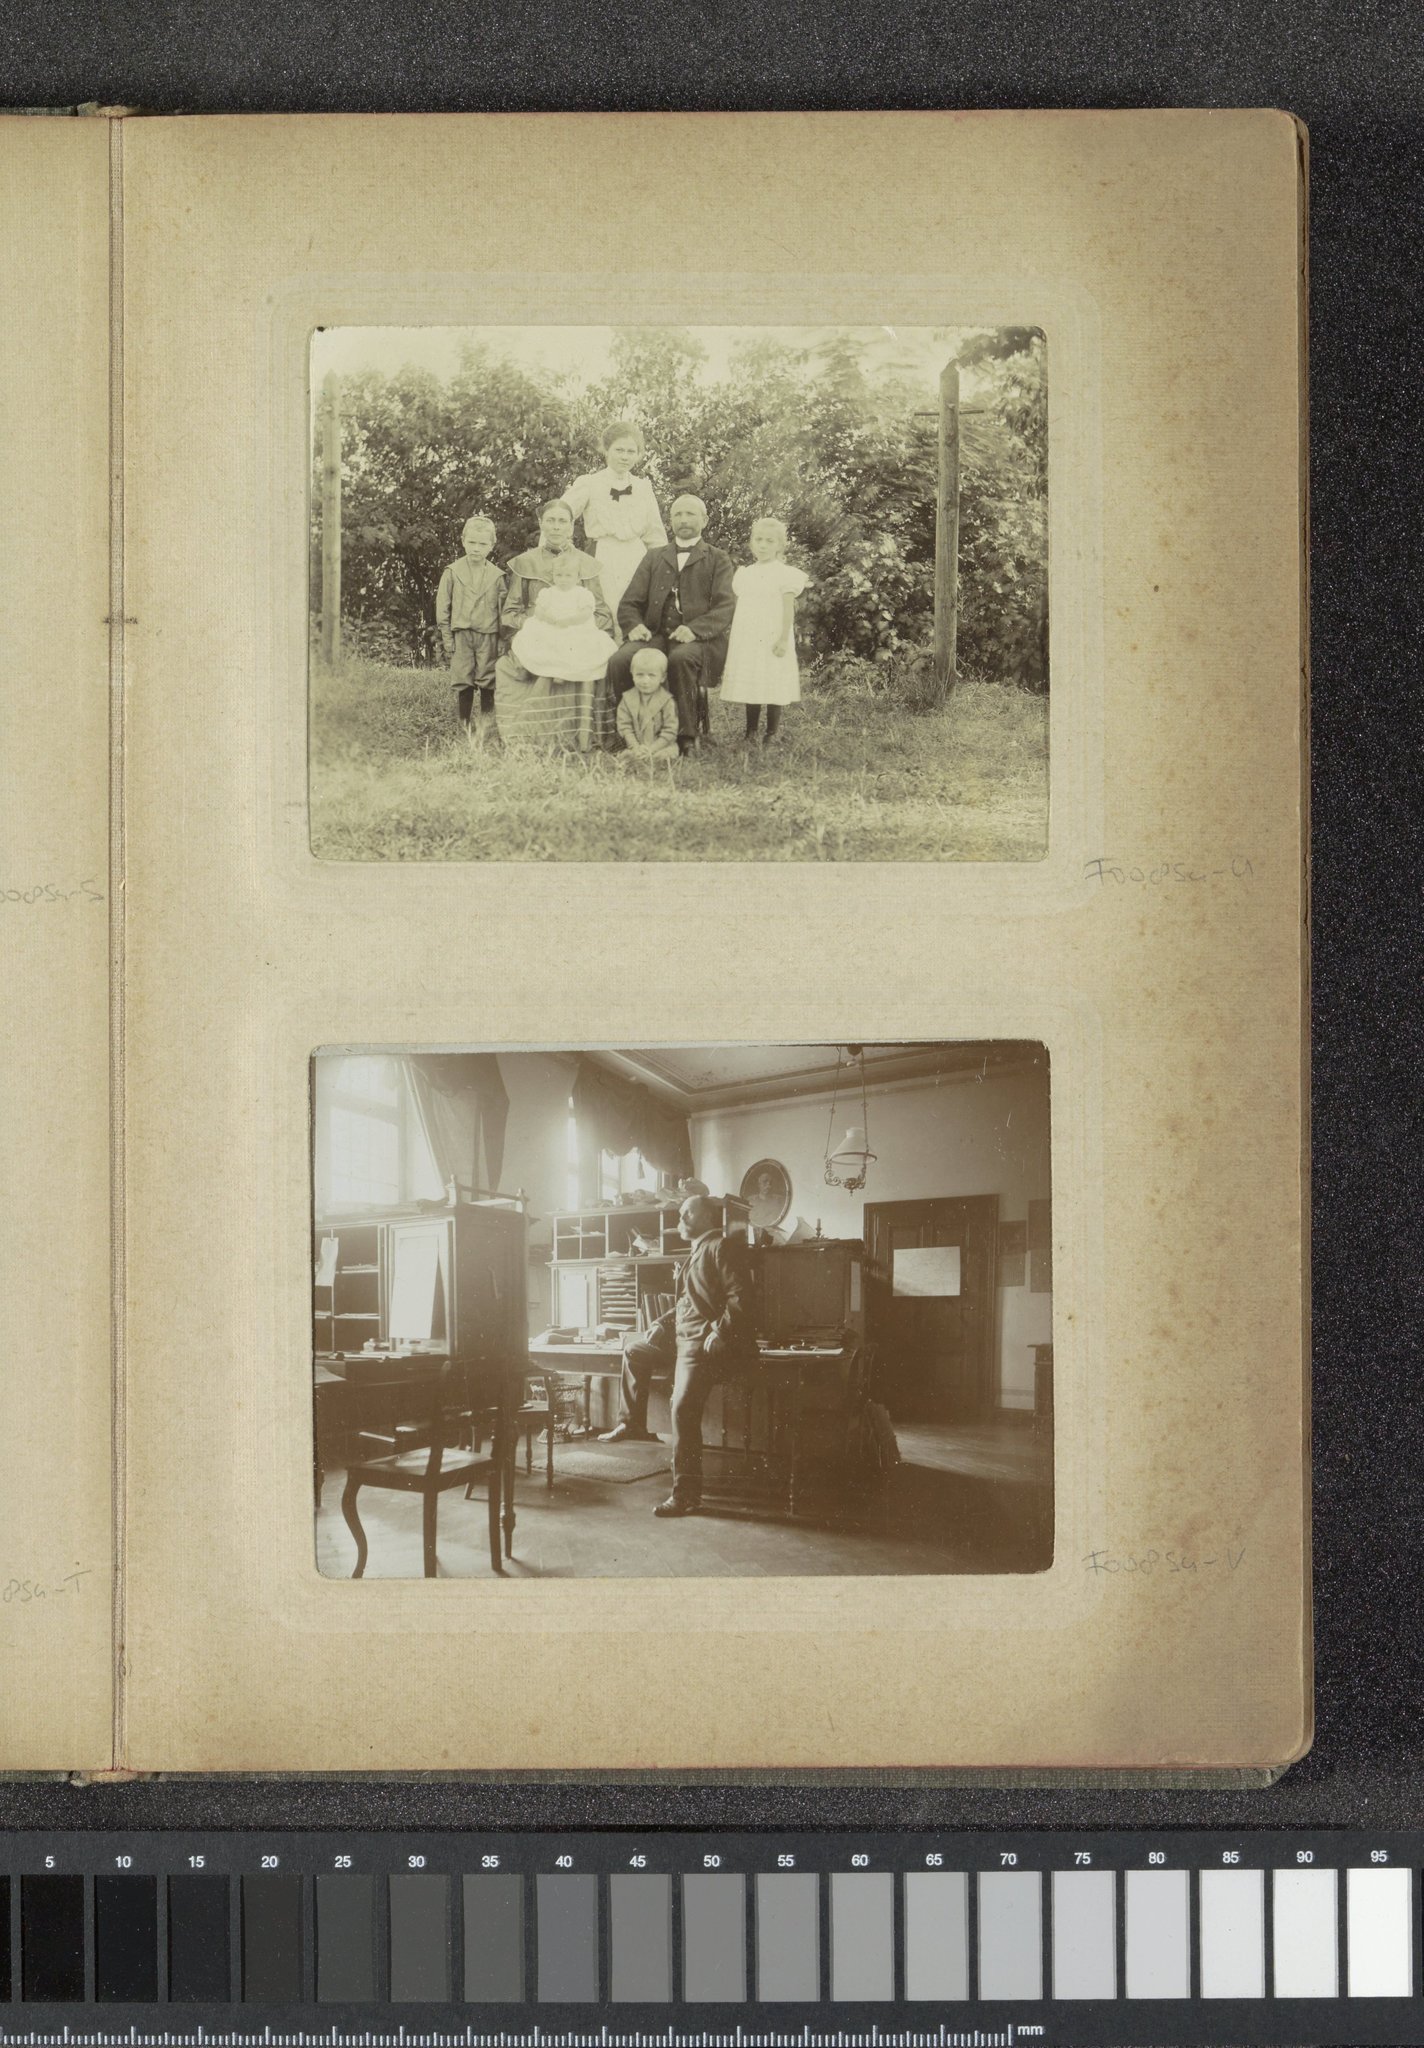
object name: photograph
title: Groepsportret van een man, een vrouw, een meisje en vier kleine kinderen in tuin in Duitsland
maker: Anonymous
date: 1890-1910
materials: cardboard, paper, photographic support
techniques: daylight paper print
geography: germany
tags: parents with their children, garden, germany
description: Onderdeel van Fotoalbum van Carl Heinrich Fliegenschmidt, gevangenisdirecteur te Oslebshausen.